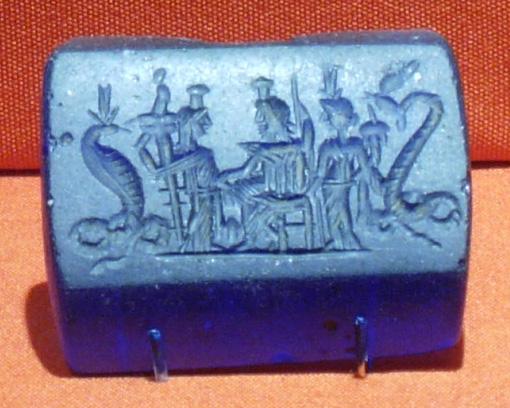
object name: plaque, five god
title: Plaque depicting Thermouthis, Demeter, Serapis, Isis, Agathodaimon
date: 101-200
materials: glass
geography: egypt